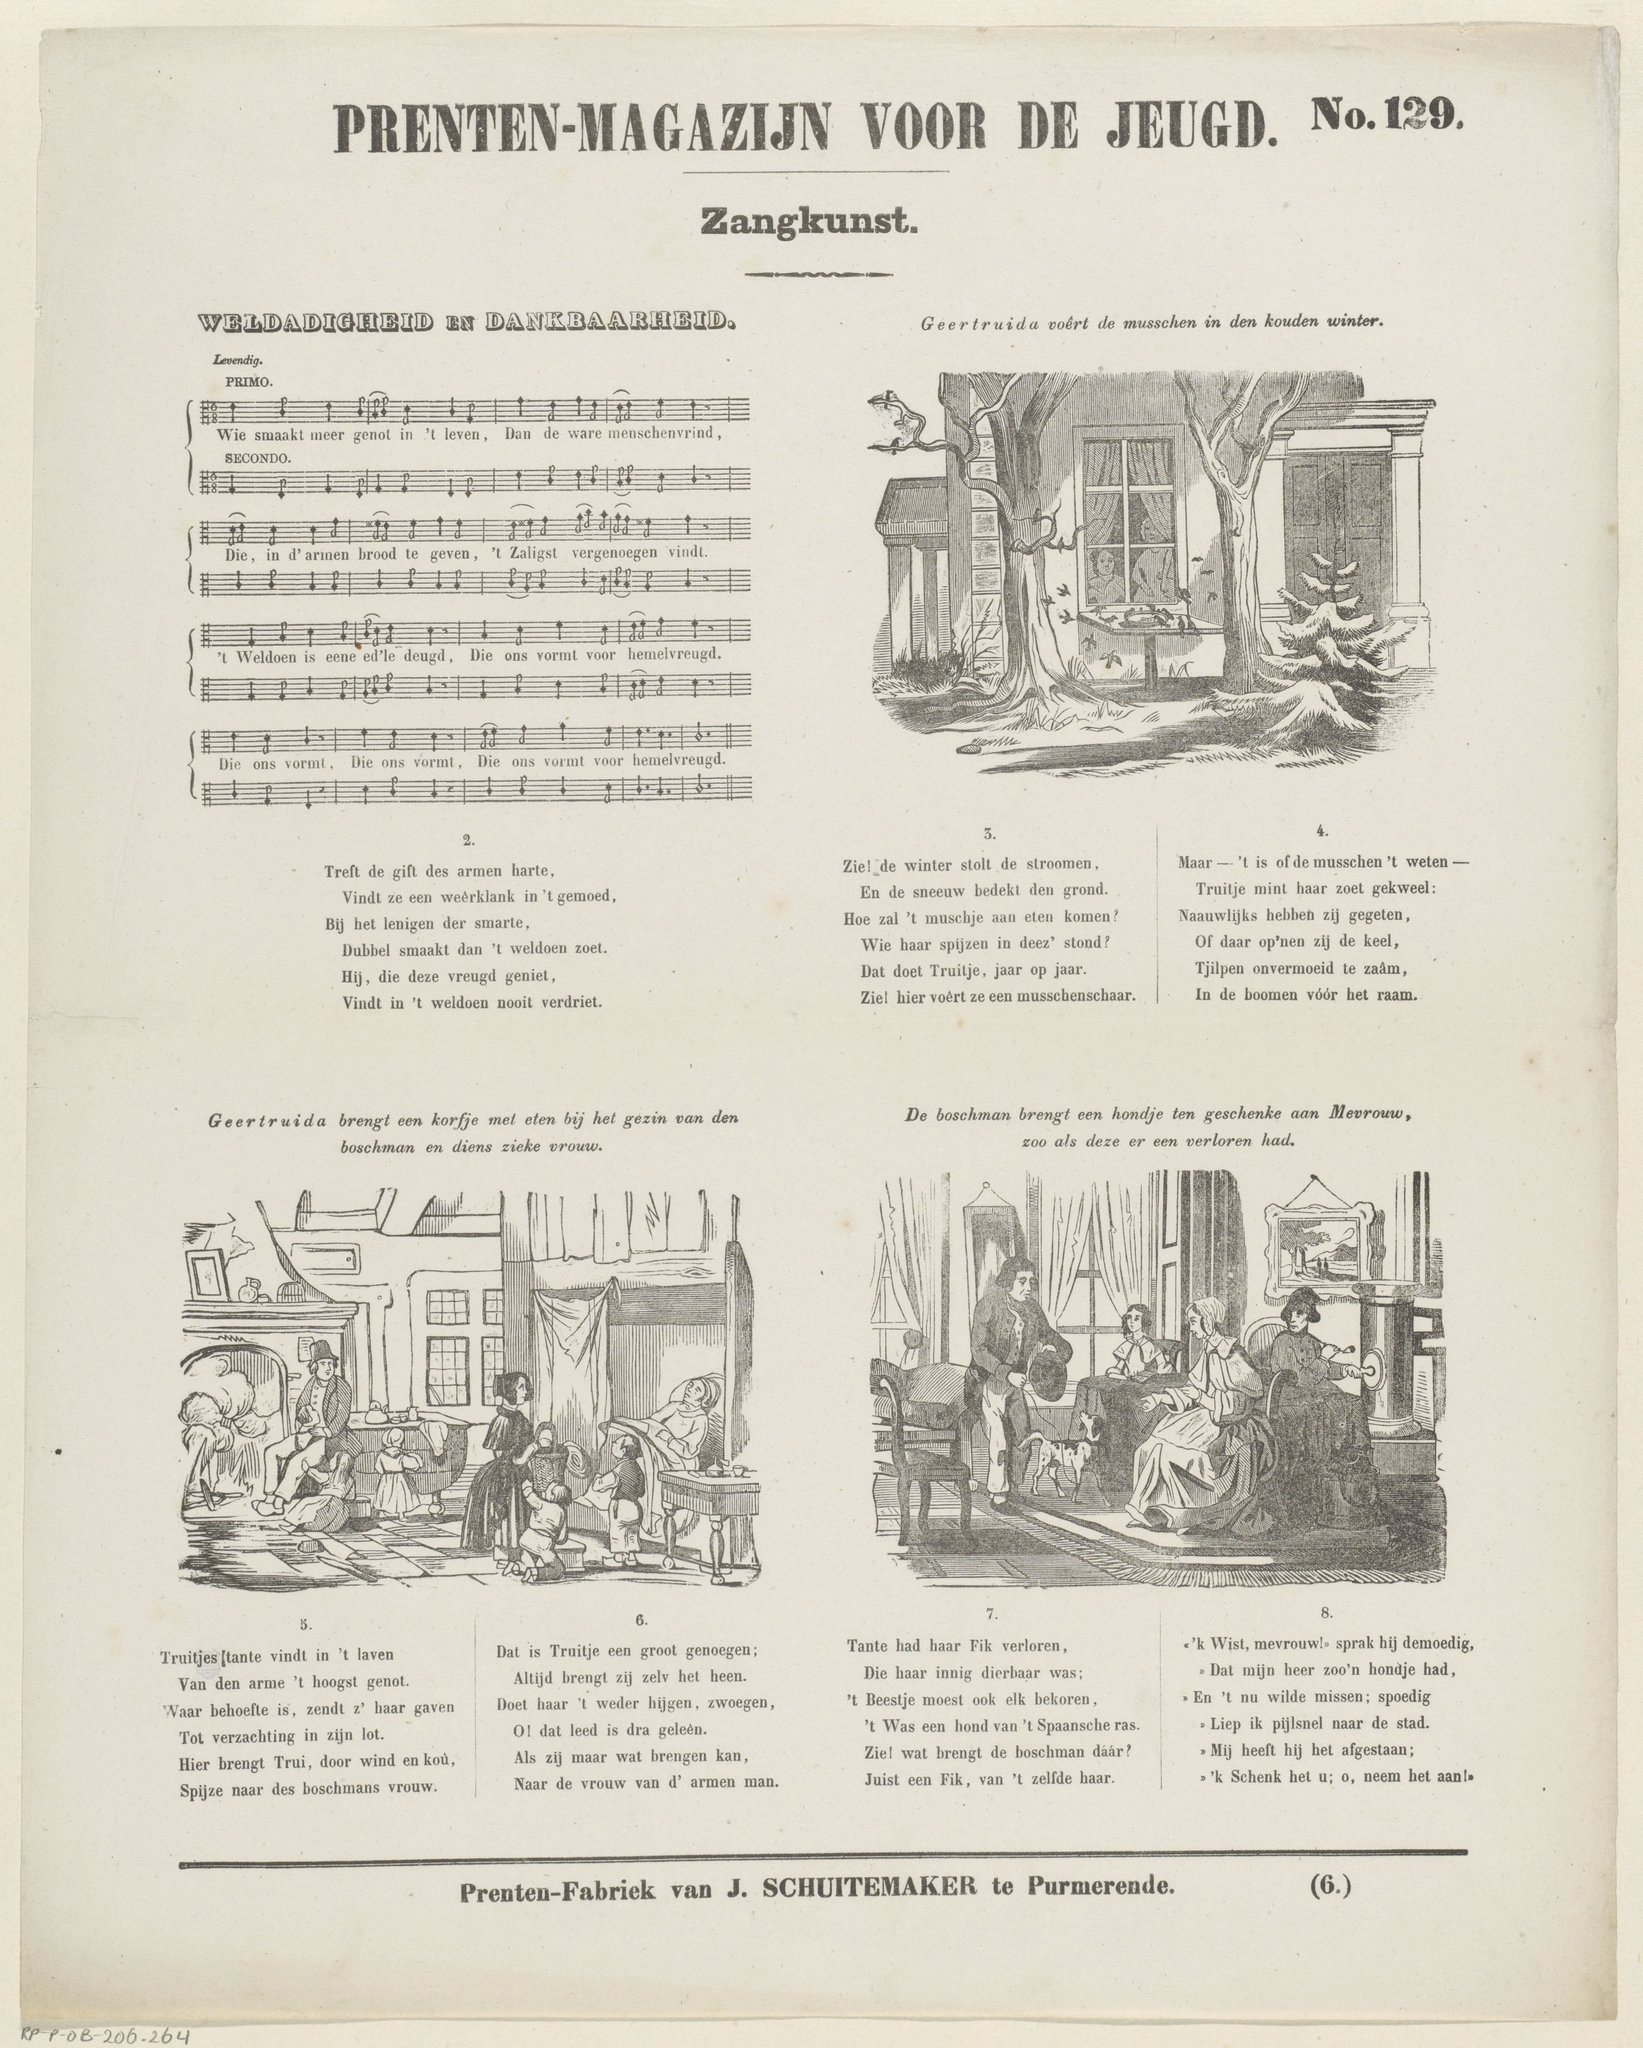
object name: print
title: Weldadigheid en dankbaarheid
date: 1850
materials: paper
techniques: letterpress printing, engraving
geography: purmerend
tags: benevolence, beneficence; 'beneficio', 'benevolenza o affettione' (ripa), gratitude; 'gratitudine', 'memoria grata de beneficii ricevuti' (ripa)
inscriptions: collector's mark: Lugt 2760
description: Na voltooiing van de acht jaargangen van de reeks 'Prenten-magazijn voor de jeugd' in 1850 heeft Jan Schuitemaker al deze prenten heruitgegeven en omgenummerd als nr. 1 t/m 192. De oorspronkelijke jaargang wordt telkens nog vermeld rechtsonder op de prent. Binnen de jaargangen zijn prenten van hetzelfde thema in clusters van vier achter elkaar gezet.